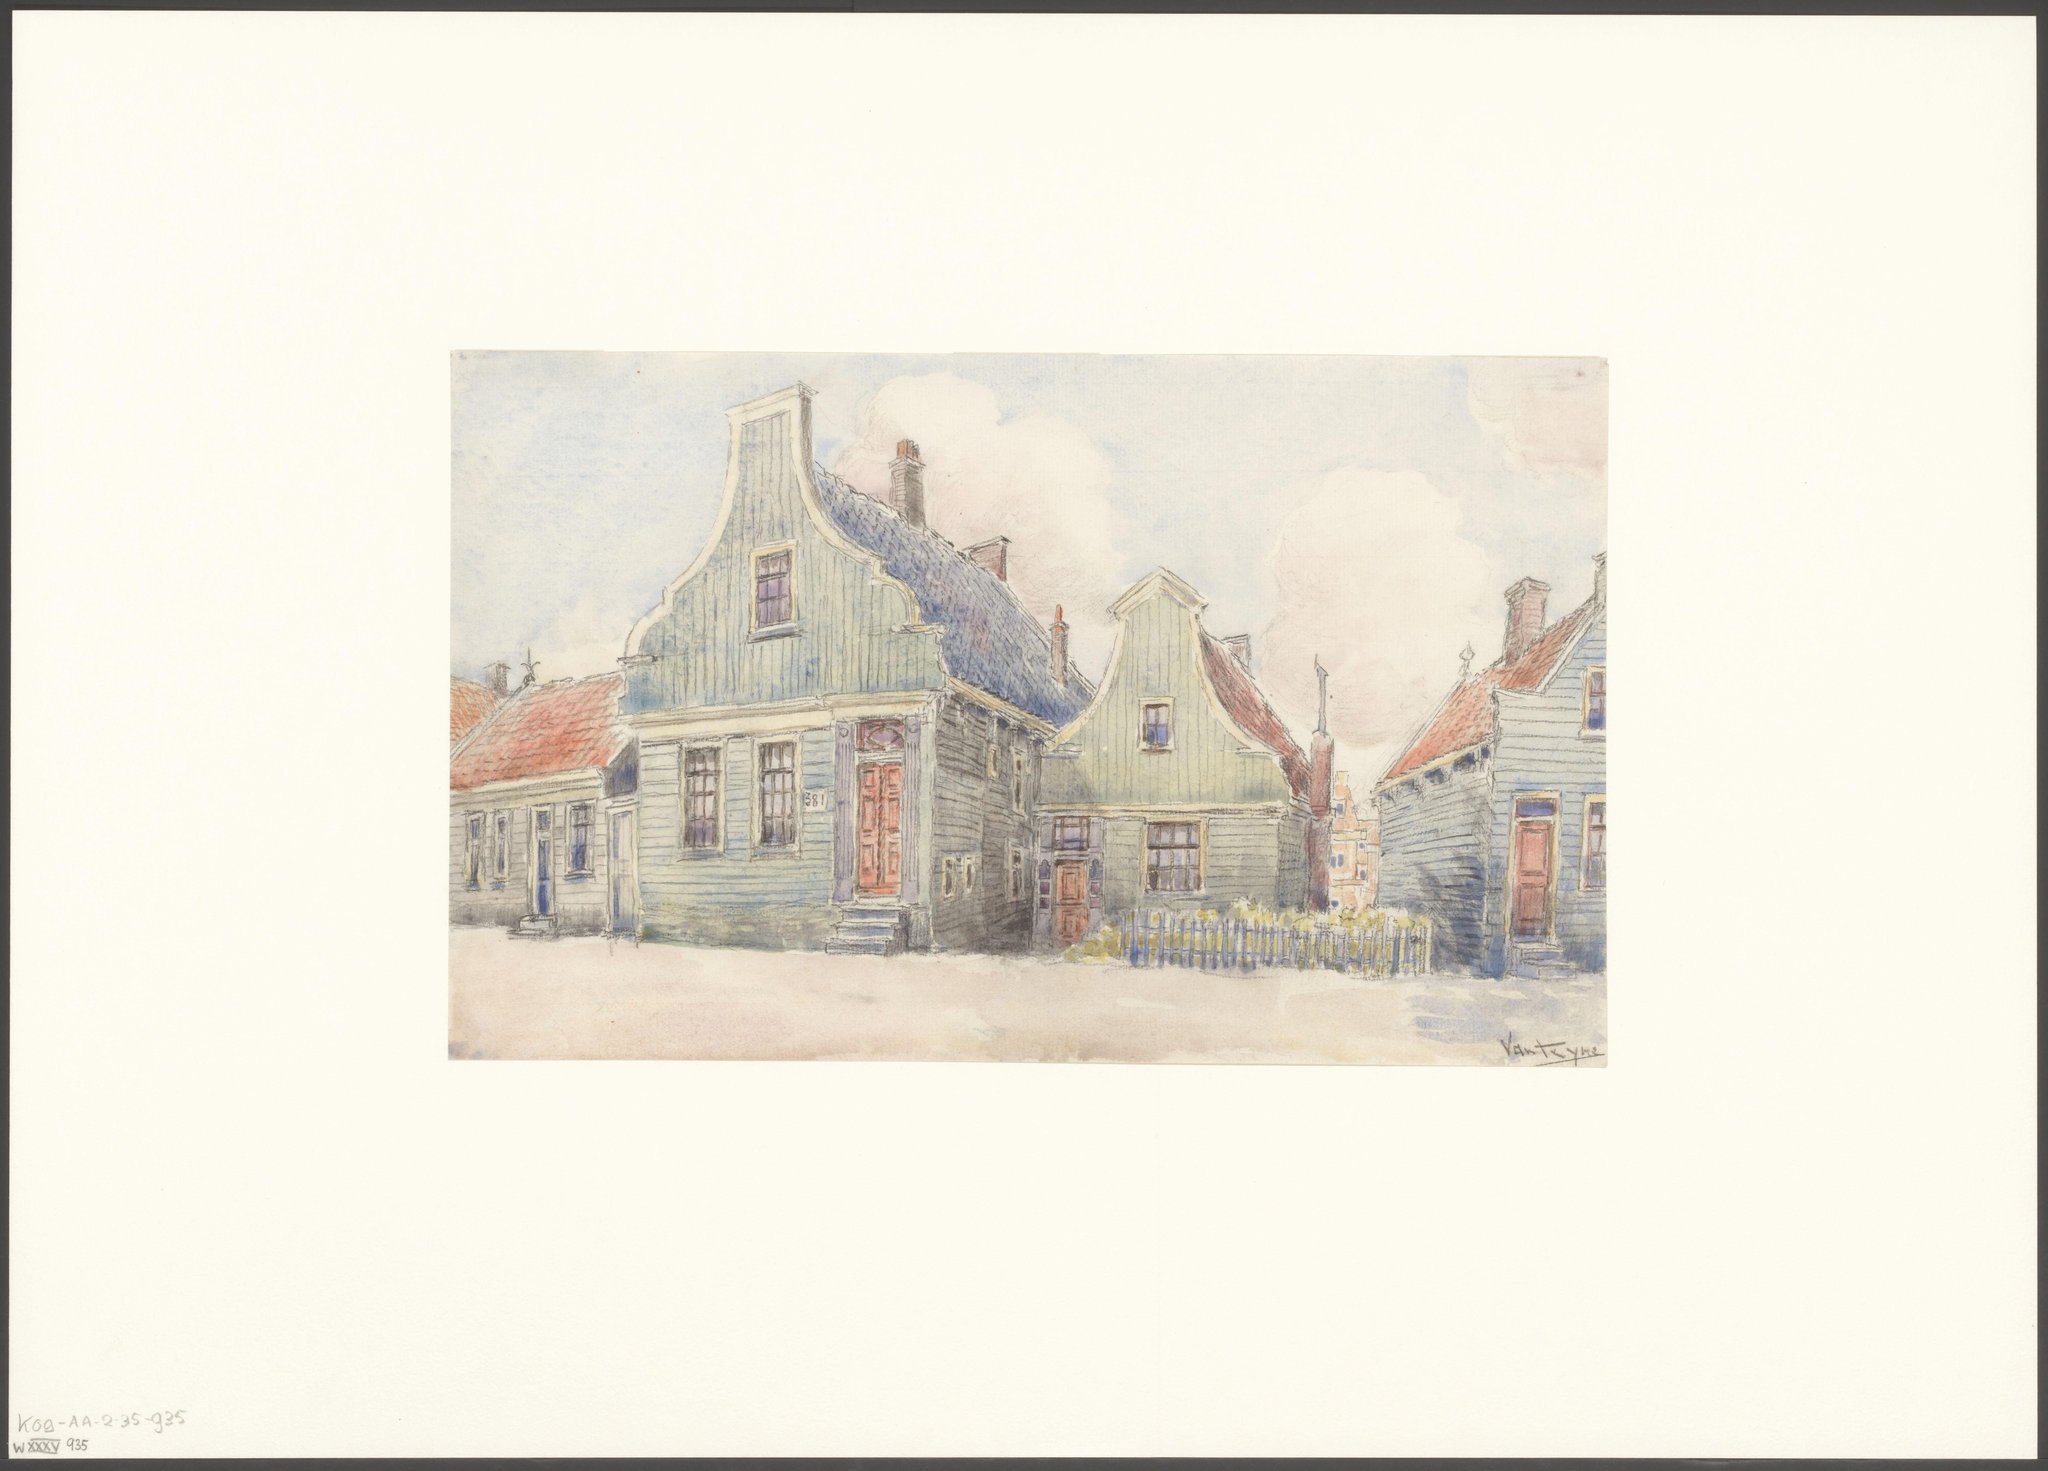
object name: drawing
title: Gezicht op de Nieuwendammerdijk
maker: anthonie van teijn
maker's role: draughtsman, painter, print maker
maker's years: 1863-1943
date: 1928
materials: chalk, paper, watercolor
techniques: brush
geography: amsterdam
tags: village, the usual house or row of houses, street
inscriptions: signature: ‘VanTeyne’, collector's mark: Lugt 800a, inscription: ‘Nieuwendam. Nieuwendammer dijk - 1928’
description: Tekening binnen de Atlas Van Eck ingedeeld op wijknummer 35.